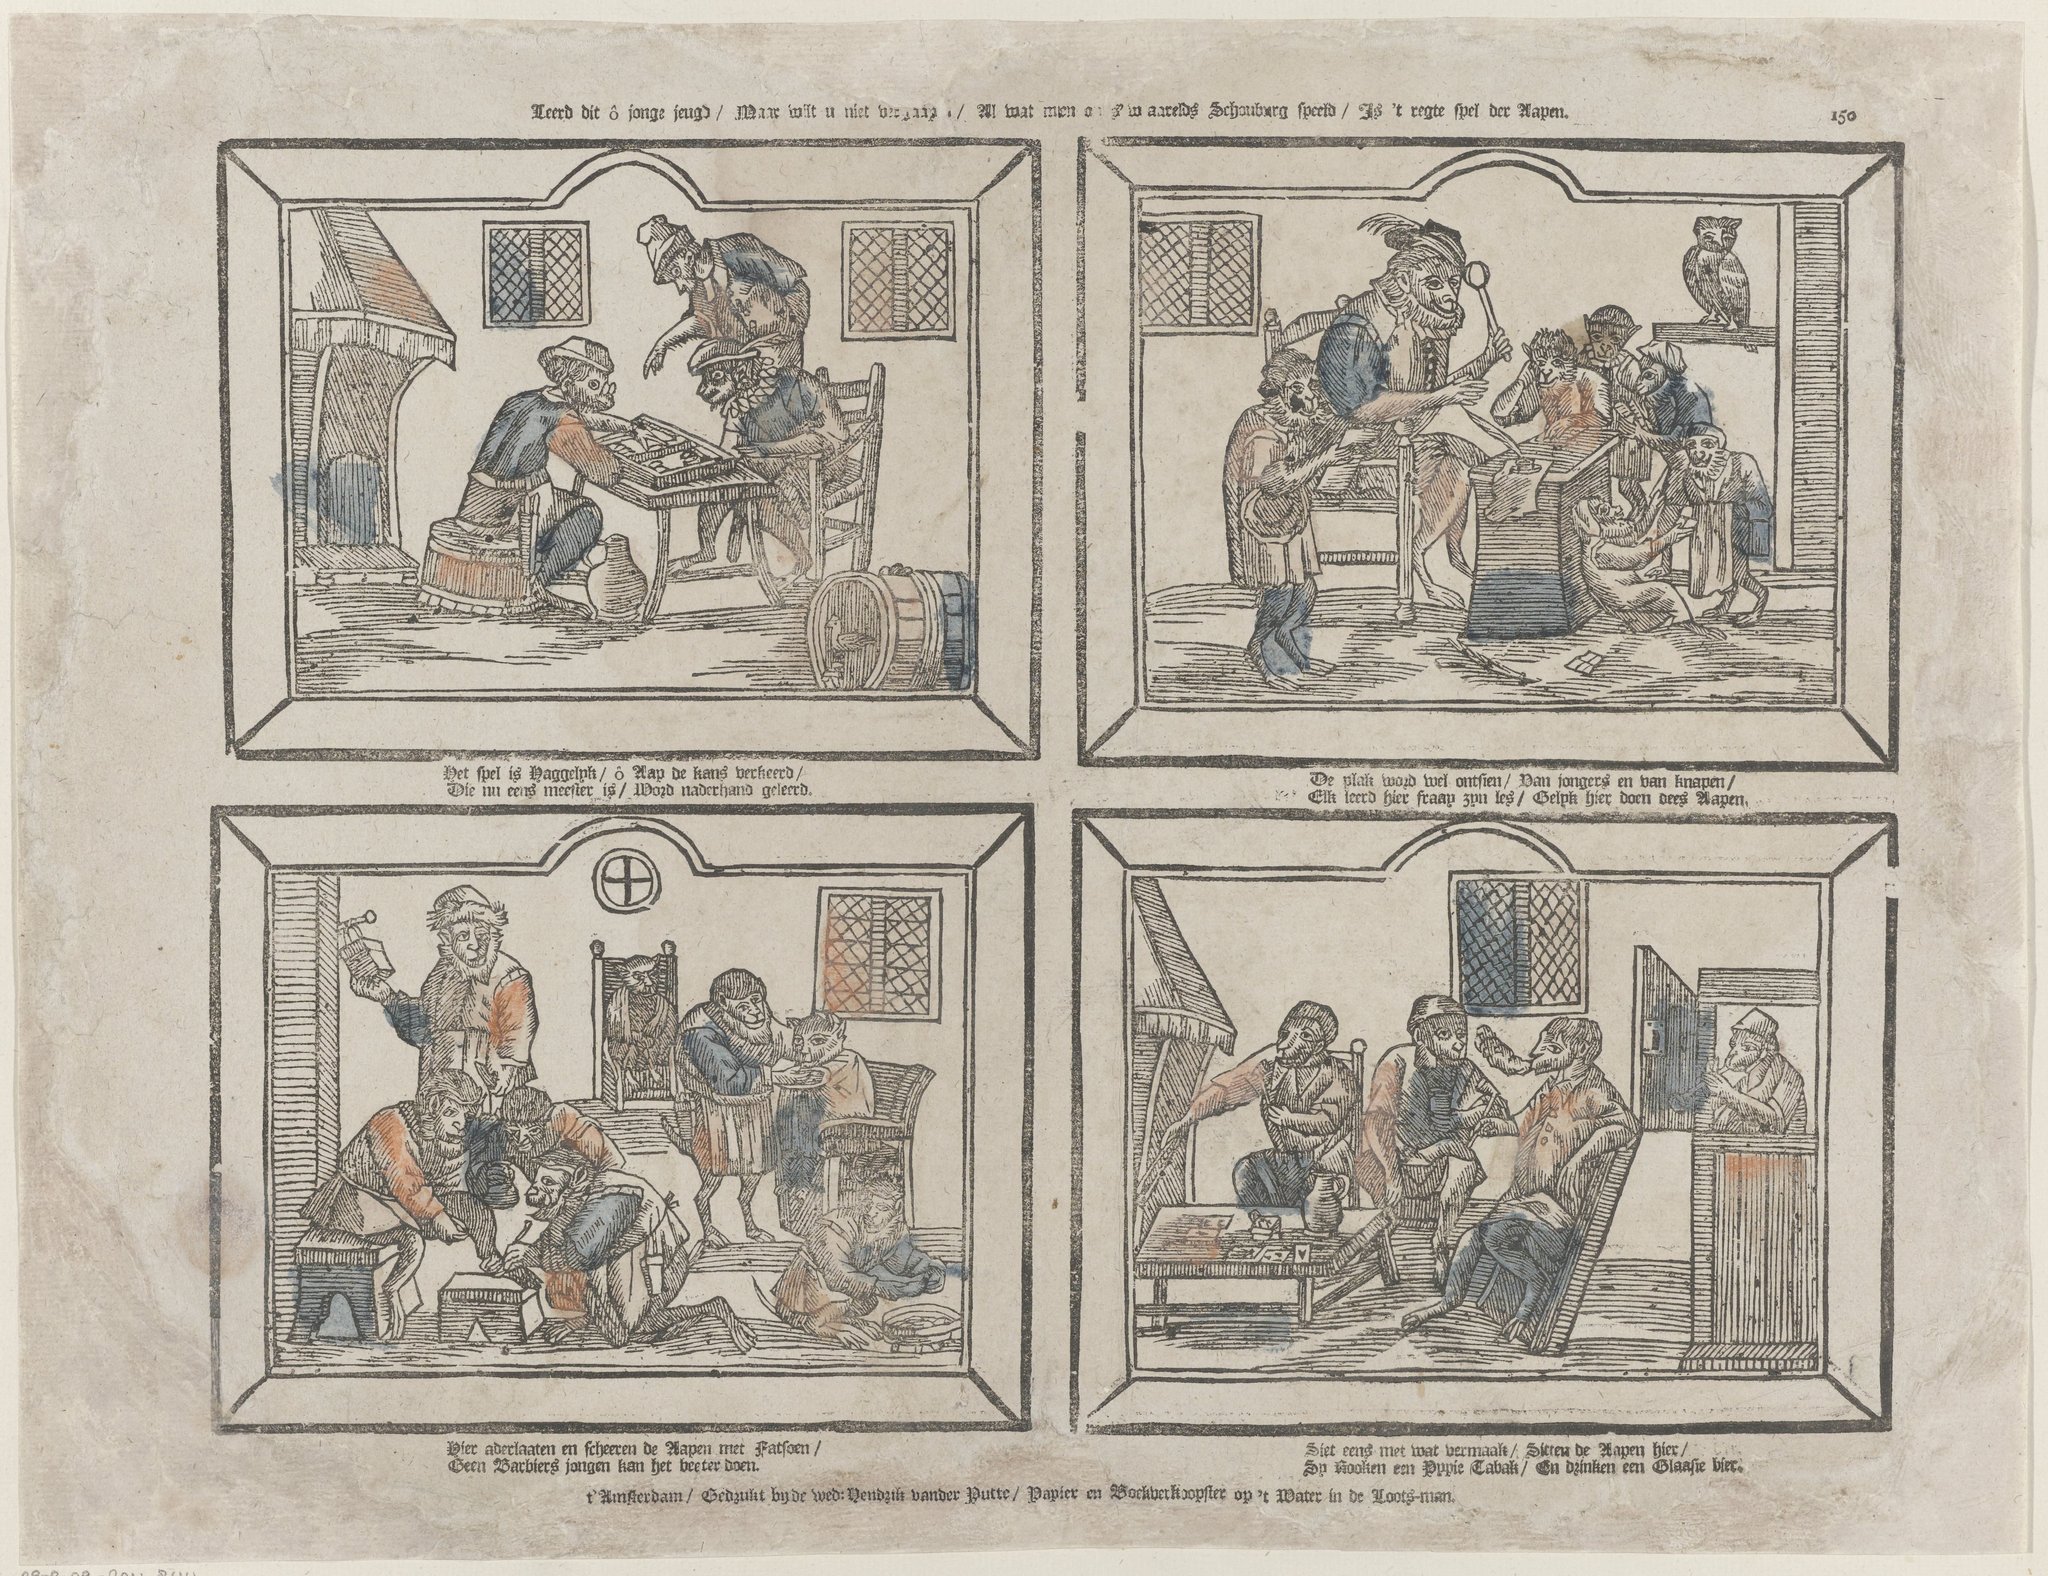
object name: popular print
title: Leerd dit o jonge jeugd / Maar wilt u niet vergaapen / Al wat men op 's waerelds schouwburg spreid / Is 't regte spel der aapen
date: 1765-1767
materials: paper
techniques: colour, letterpress printing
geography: netherlands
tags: monkeys, apes, 'mundus inversus', the reversed world, the topsy-turvy world, 'le monde bestourné'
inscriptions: collector's mark: Lugt 2760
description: Blad met 4 taferelen met apen die zich gedragen als mensen. Onder elke afbeelding een vers. Genummerd rechtsboven: 150.